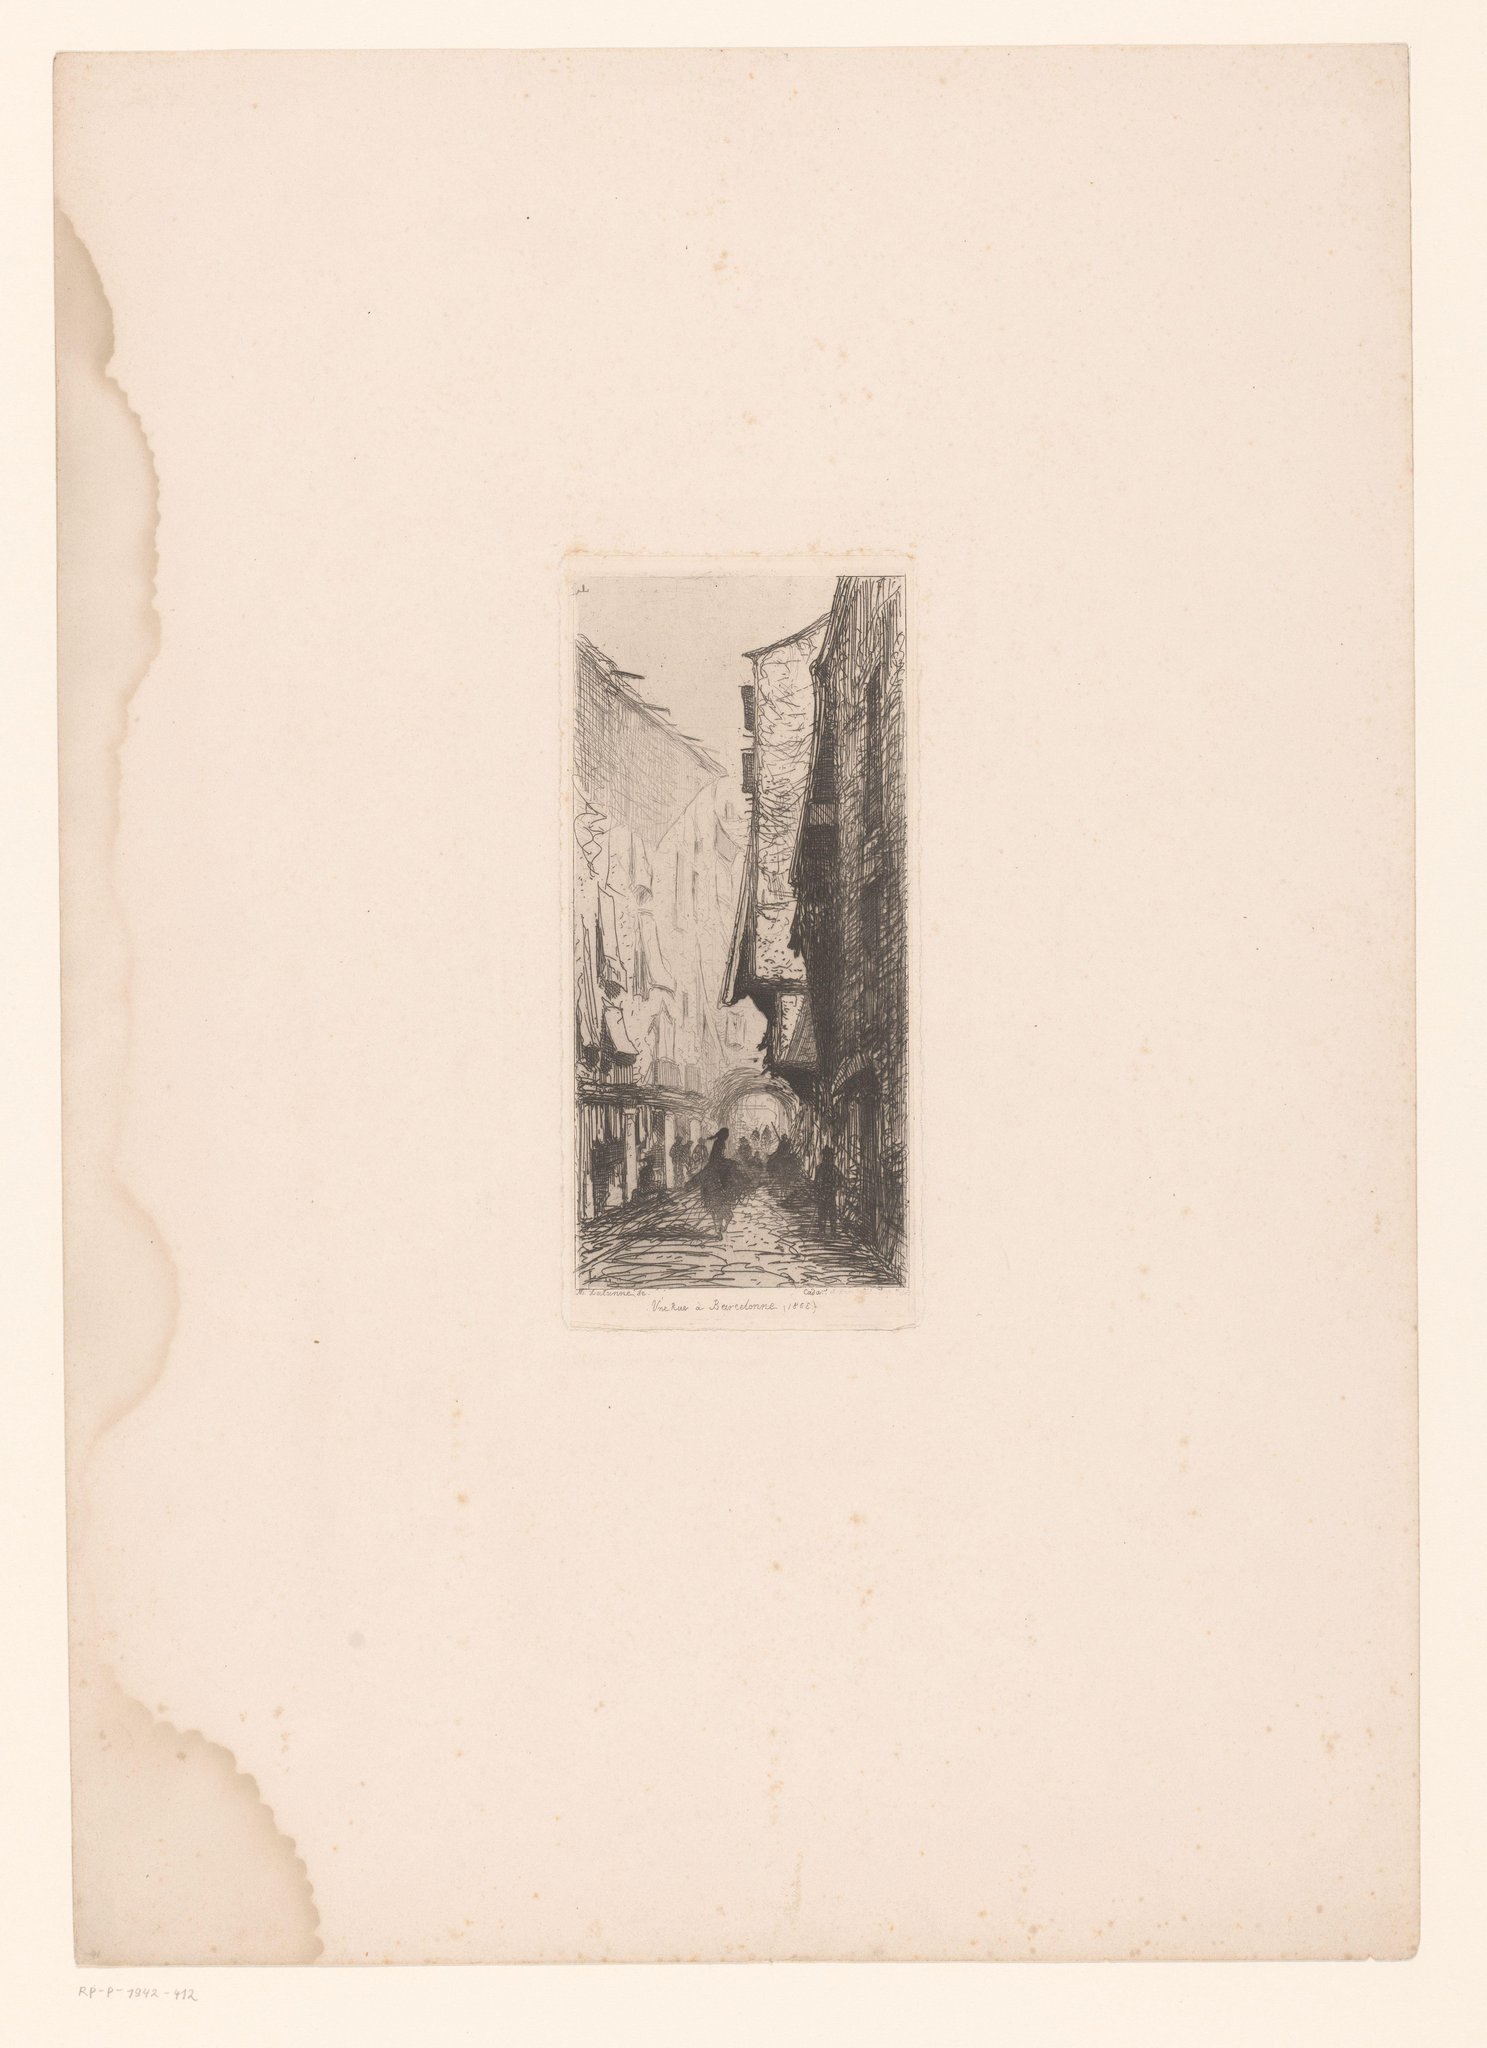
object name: print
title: Straatzicht in Barcelona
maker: maxime françois antoine lalanne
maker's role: draughtsman, print maker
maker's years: 1827-1886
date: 1863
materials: paper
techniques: drypoint, engraving, etching, intaglio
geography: france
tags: city-view in general; 'veduta', street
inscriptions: collector's mark: Lugt 2228, collector's mark: Lugt 2760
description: Gepubliceerd in: "Douze croquis à l'eau-forte (...)".